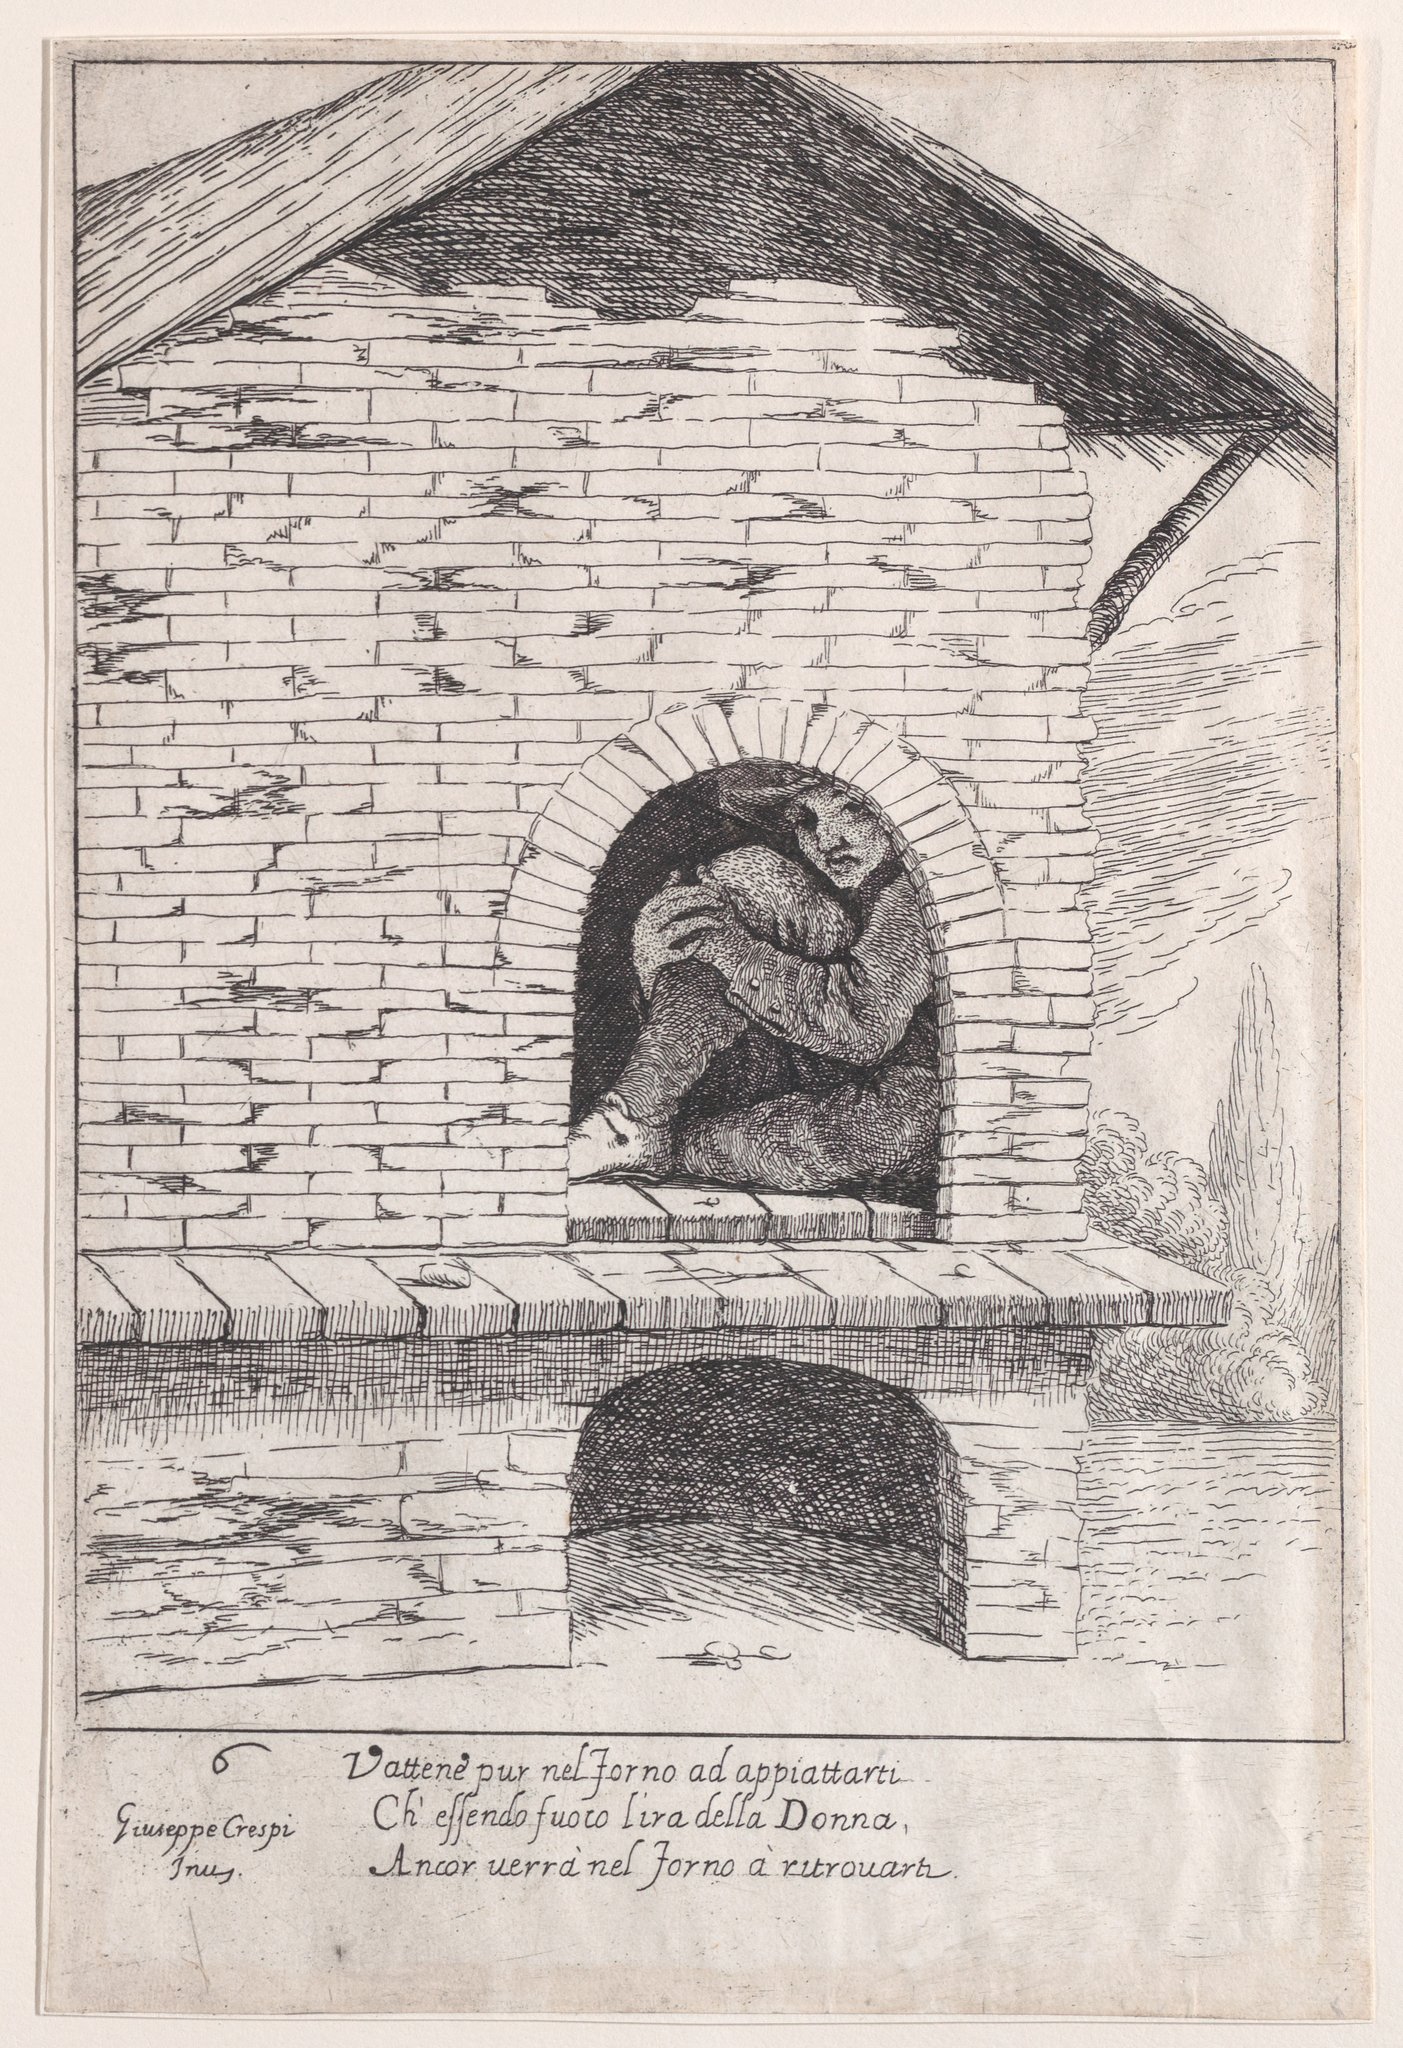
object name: print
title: Plate 6: Bertoldo hidden in a furnace, from "Bertoldo, Bertoldino, and Cacasenno"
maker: giuseppe maria crespi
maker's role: artist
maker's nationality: italian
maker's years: 1665-1747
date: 1705-1715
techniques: etching